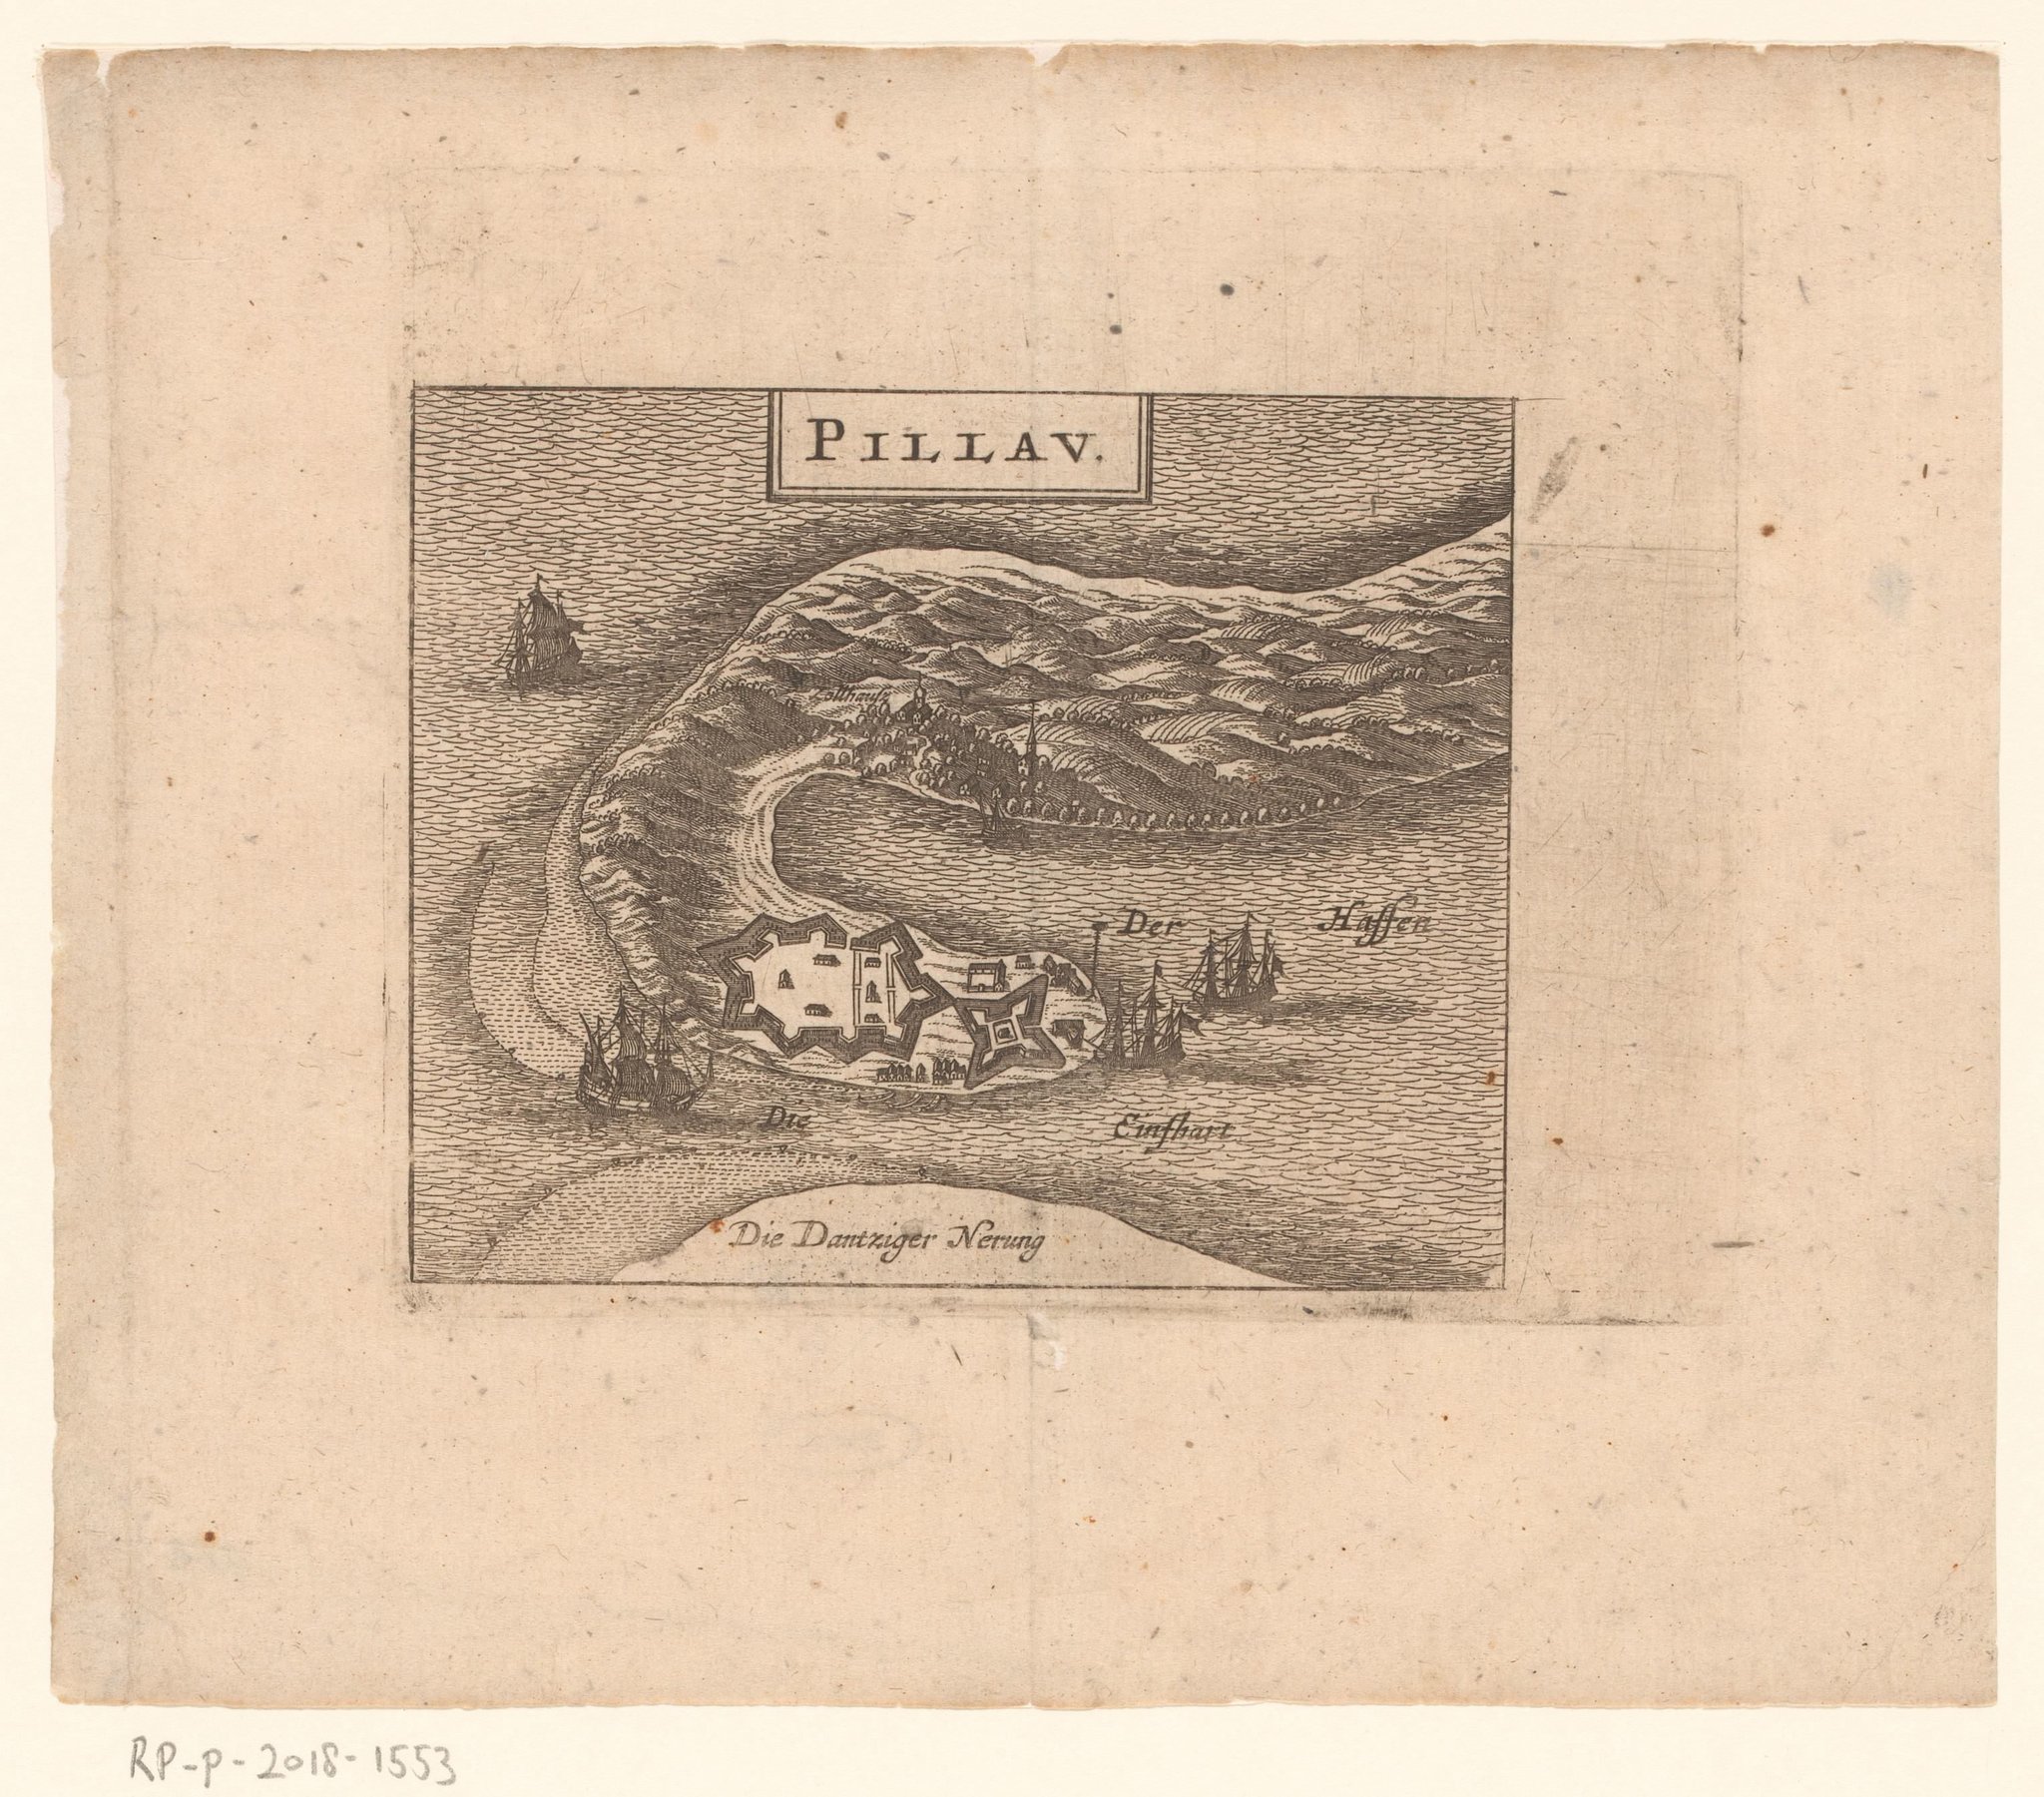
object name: print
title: Plattegrond van Pillau, tegenwoordig Baltiejsk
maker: matthäus merian (i)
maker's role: print maker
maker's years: 1593-1650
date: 1652-1703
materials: paper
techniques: etching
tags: maps of cities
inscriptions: collector's mark: Lugt 2228